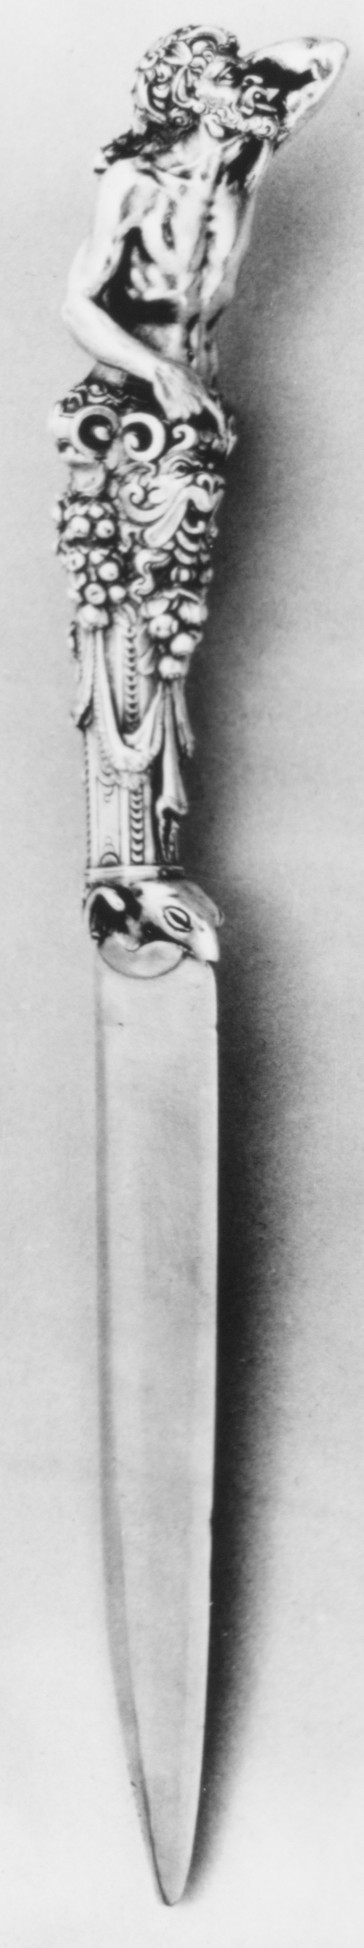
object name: knife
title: Knife (one of a set)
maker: antonio gentili (antonio da faenza)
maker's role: maker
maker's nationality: italian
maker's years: 1514-1610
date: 1567-1600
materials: gold, silver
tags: knives,satyrs